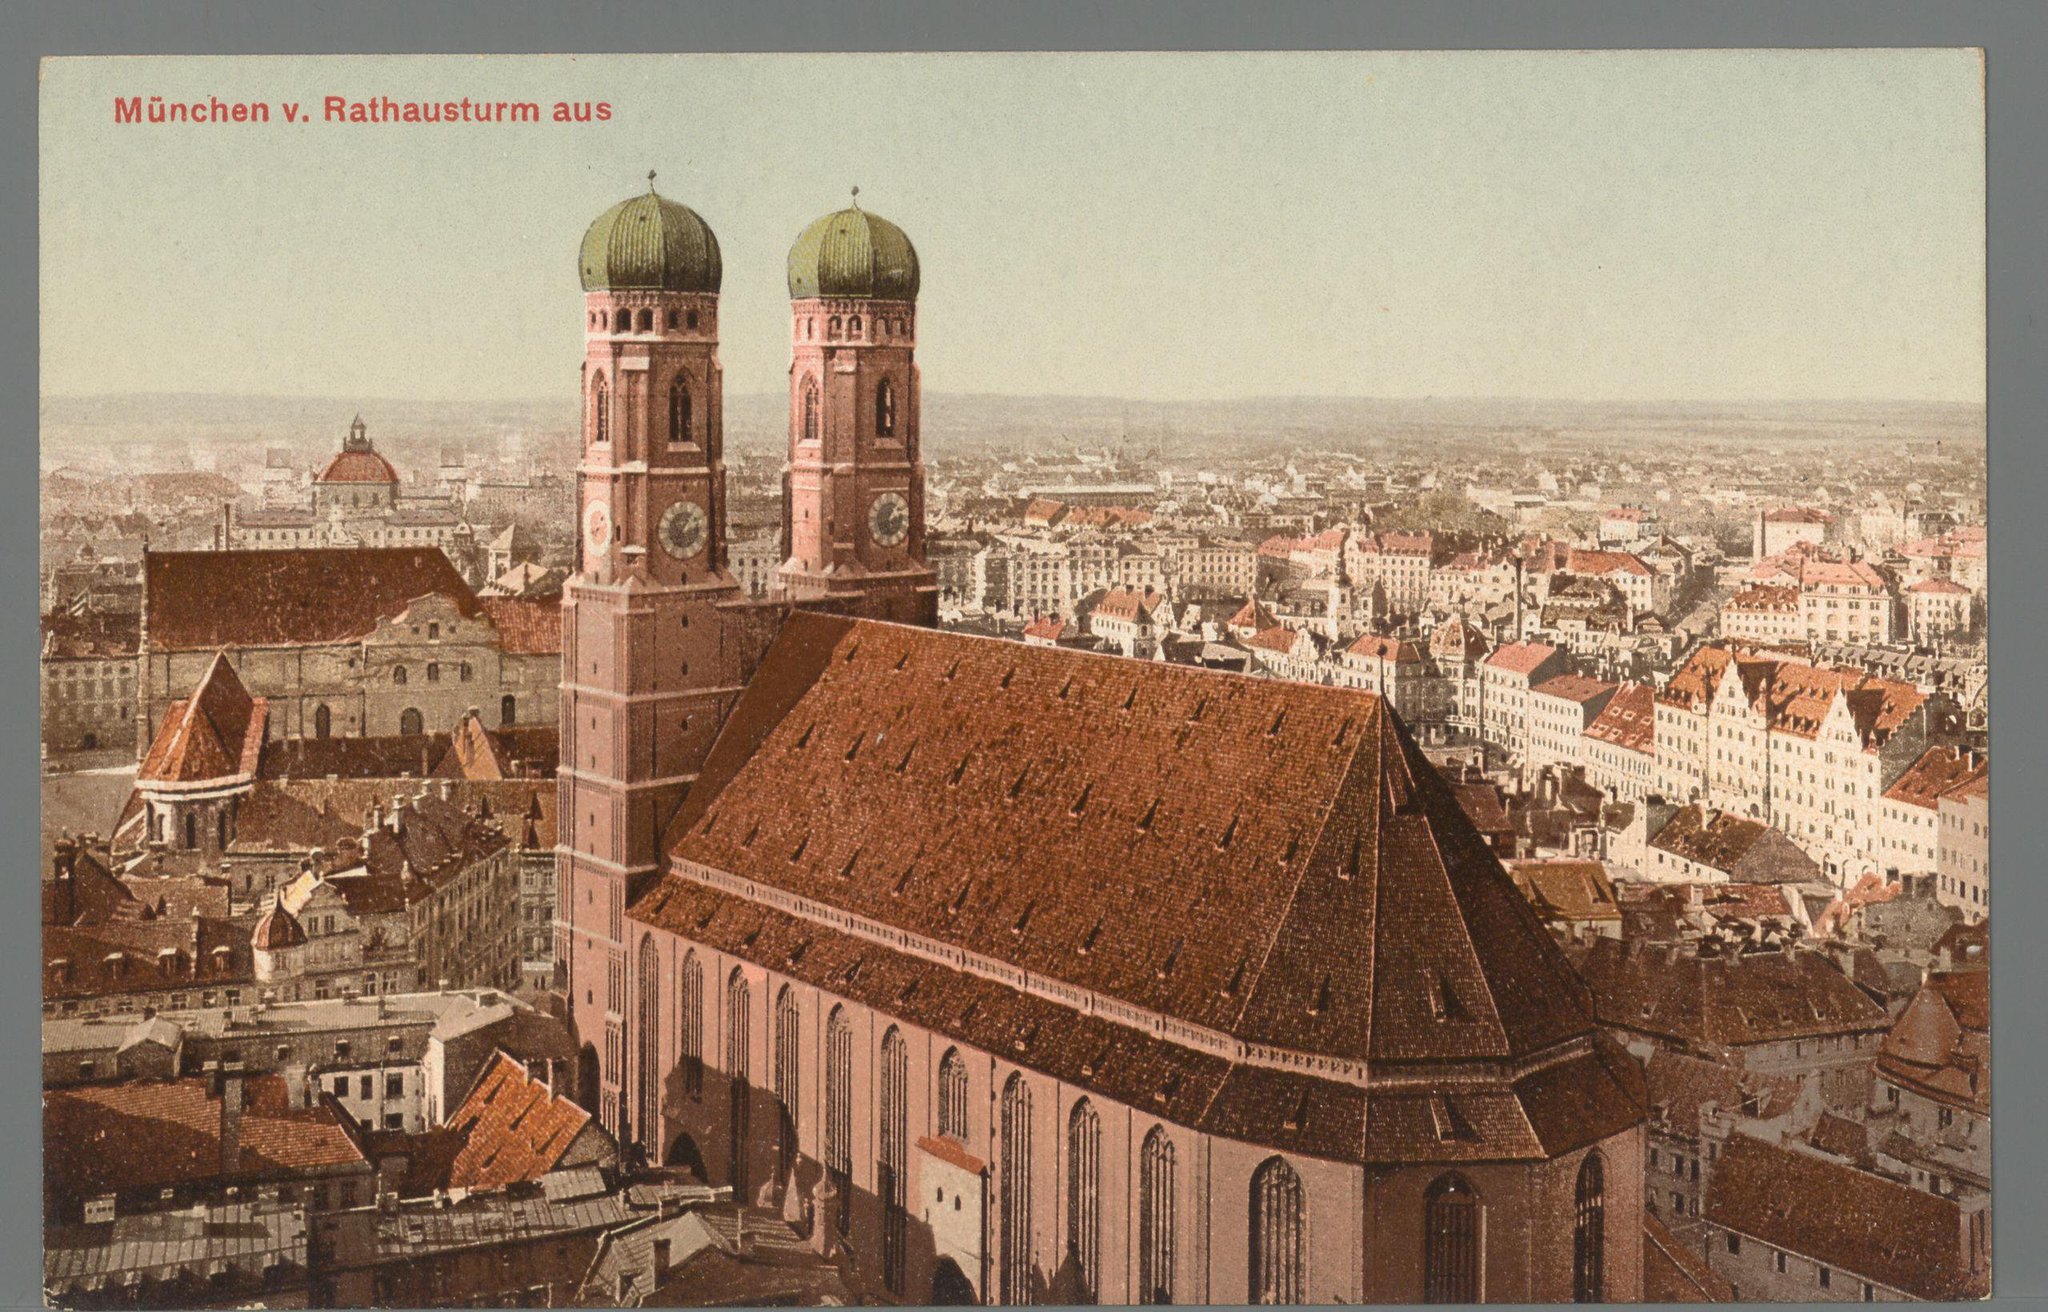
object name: ansichtkaart, prentbriefkaart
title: München v. Rathausturm aus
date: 1905-1909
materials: cardboard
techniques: lithograph, writing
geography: munich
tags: church (exterior), townhall